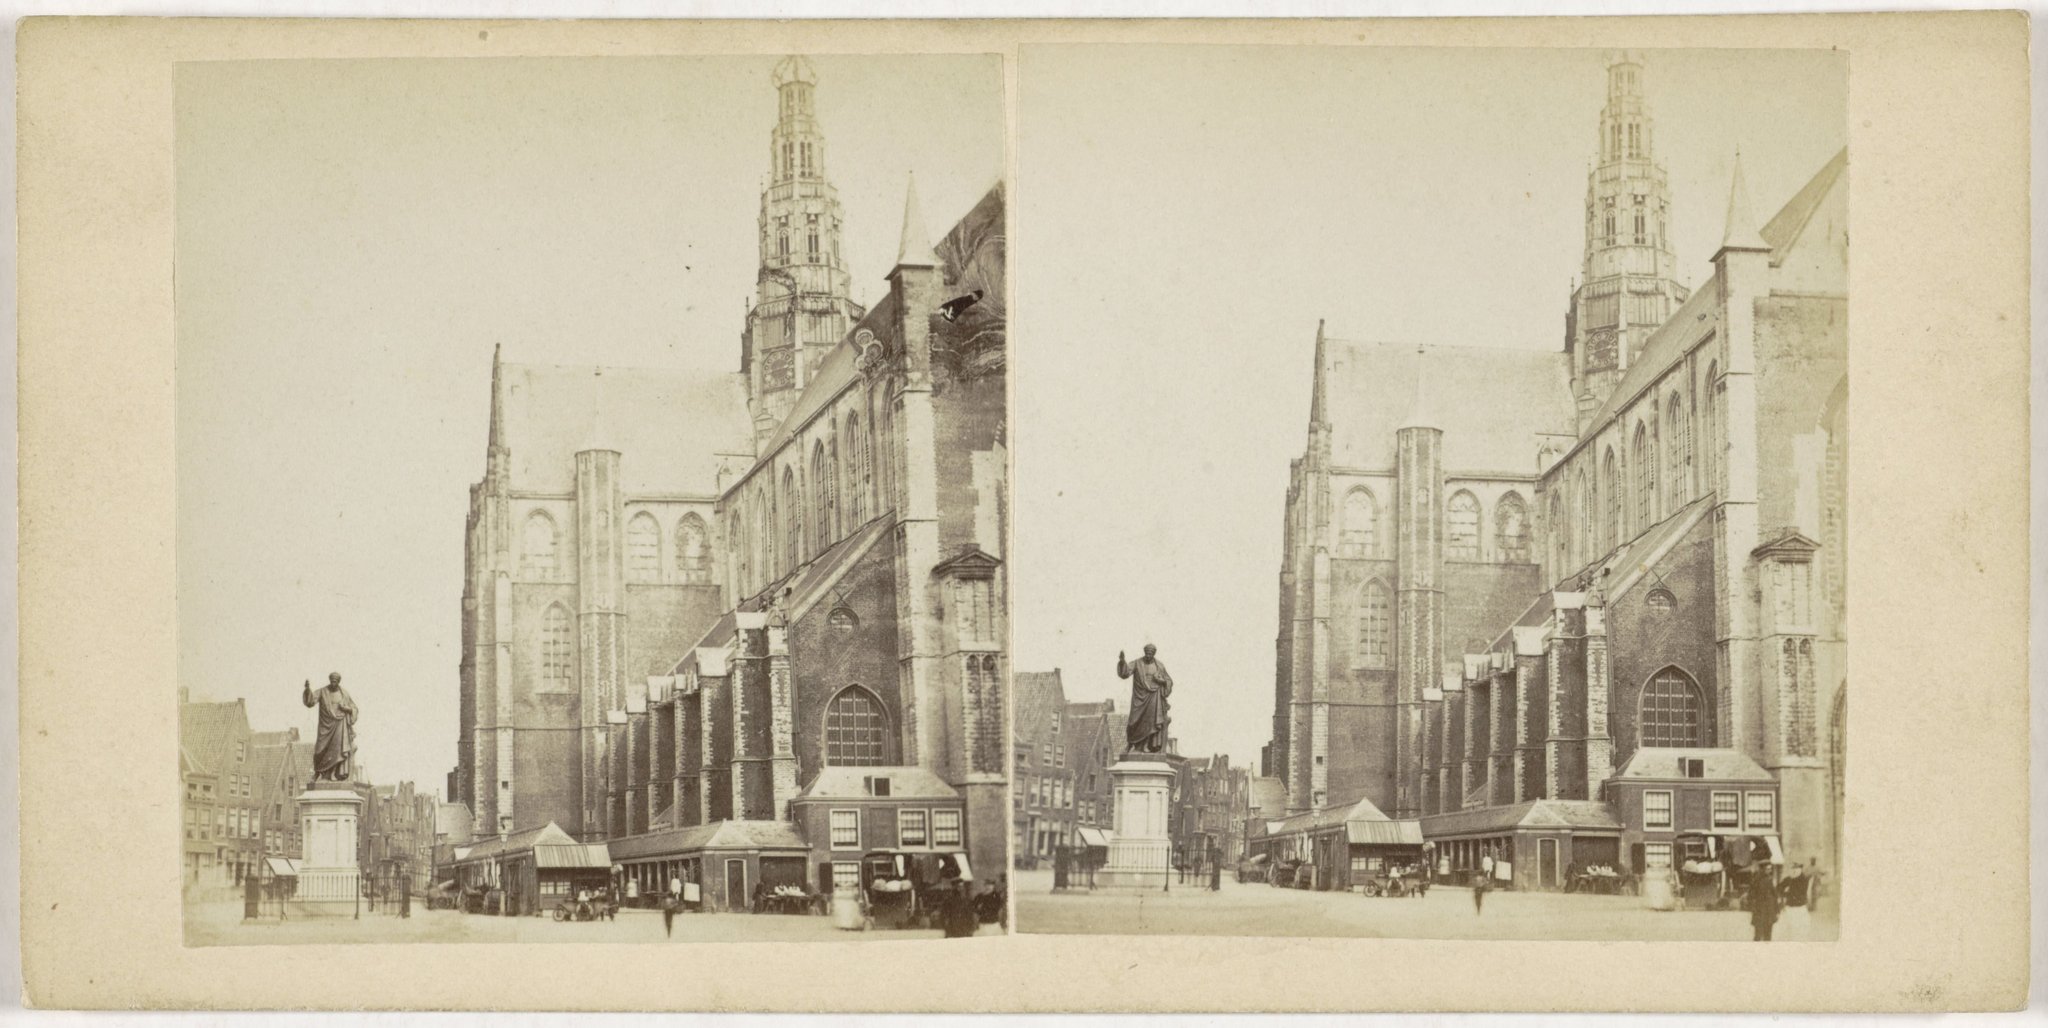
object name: stereograph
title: Gezicht op de Sint-Bavokerk en de Grote Markt in Haarlem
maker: Anonymous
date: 1857-1863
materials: cardboard, paper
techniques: albumen print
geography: haarlem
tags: square, place, circus, etc., parts of church exterior and annexes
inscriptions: inscription: ‘RBK’